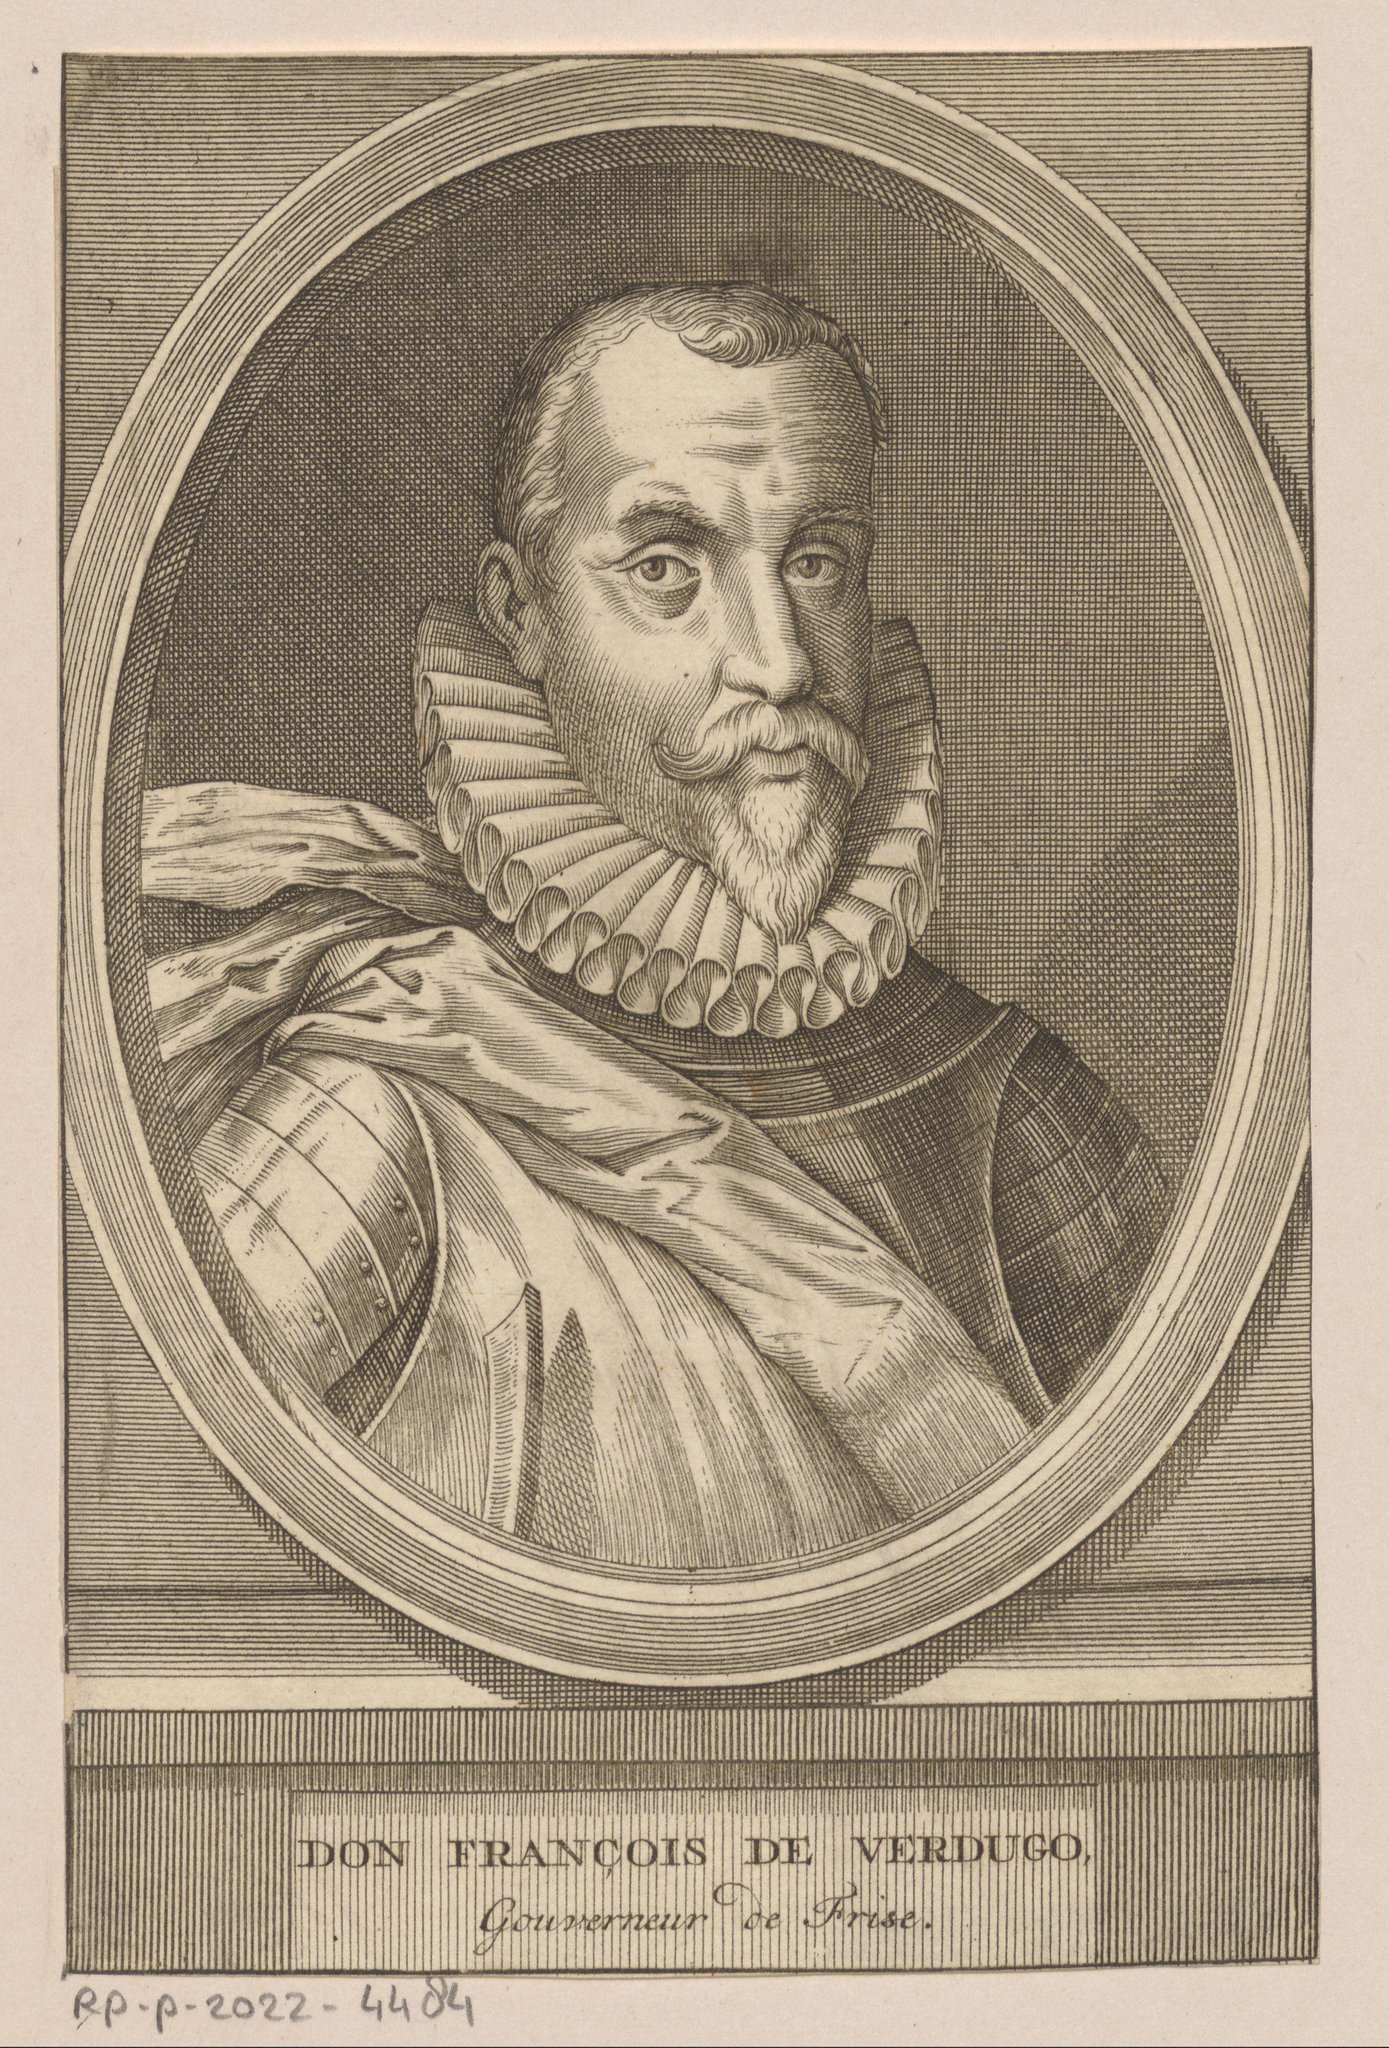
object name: print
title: 48 portretten van graven, baronnen, ridders en generaals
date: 1715-1730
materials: paper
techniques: engraving, etching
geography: leiden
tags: historical persons, stadtholder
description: Prent waarshijnlijk uit: XLVIII. portraits de plusieurs comtes, barons, chevaliers, generaux, gouverneurs & autres personnes illustres. Leiden: Pieter van der Aa, [1729?], nr, 34.